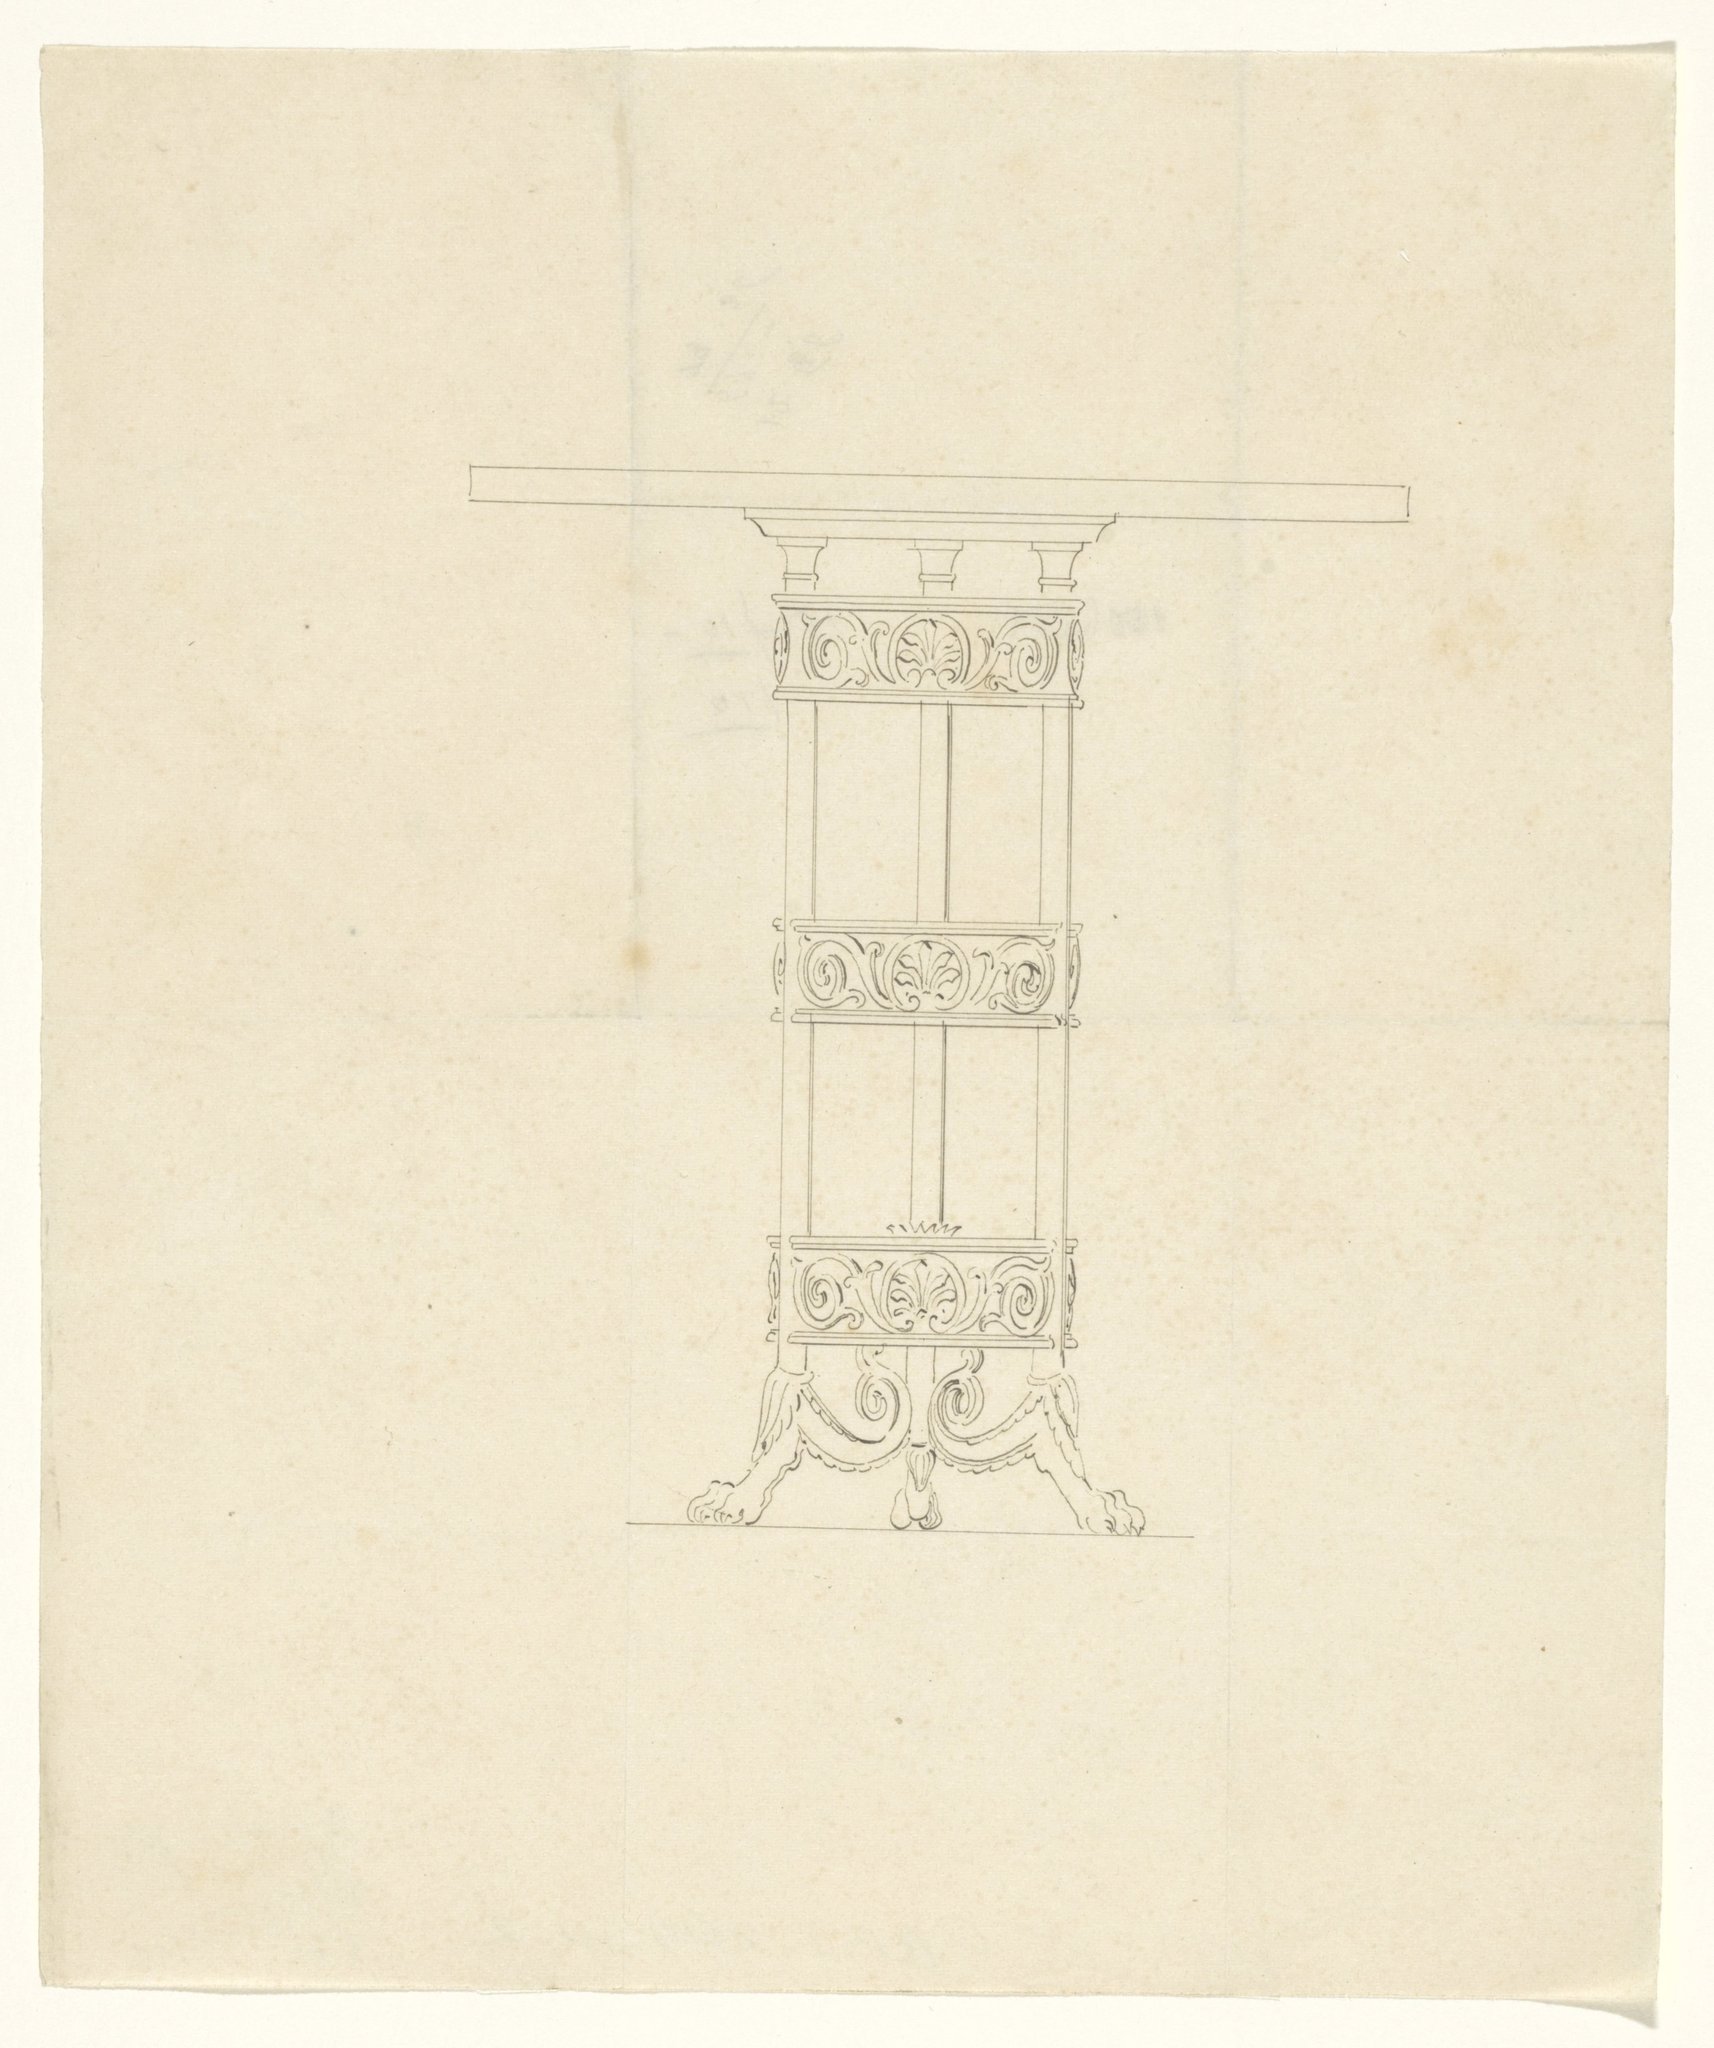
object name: drawing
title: Ronde tafel met opengewerkte voet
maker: franz jakob kreuter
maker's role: architect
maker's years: 1813-1889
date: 1835-1860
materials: ink, paper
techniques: pen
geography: munich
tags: table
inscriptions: inscription